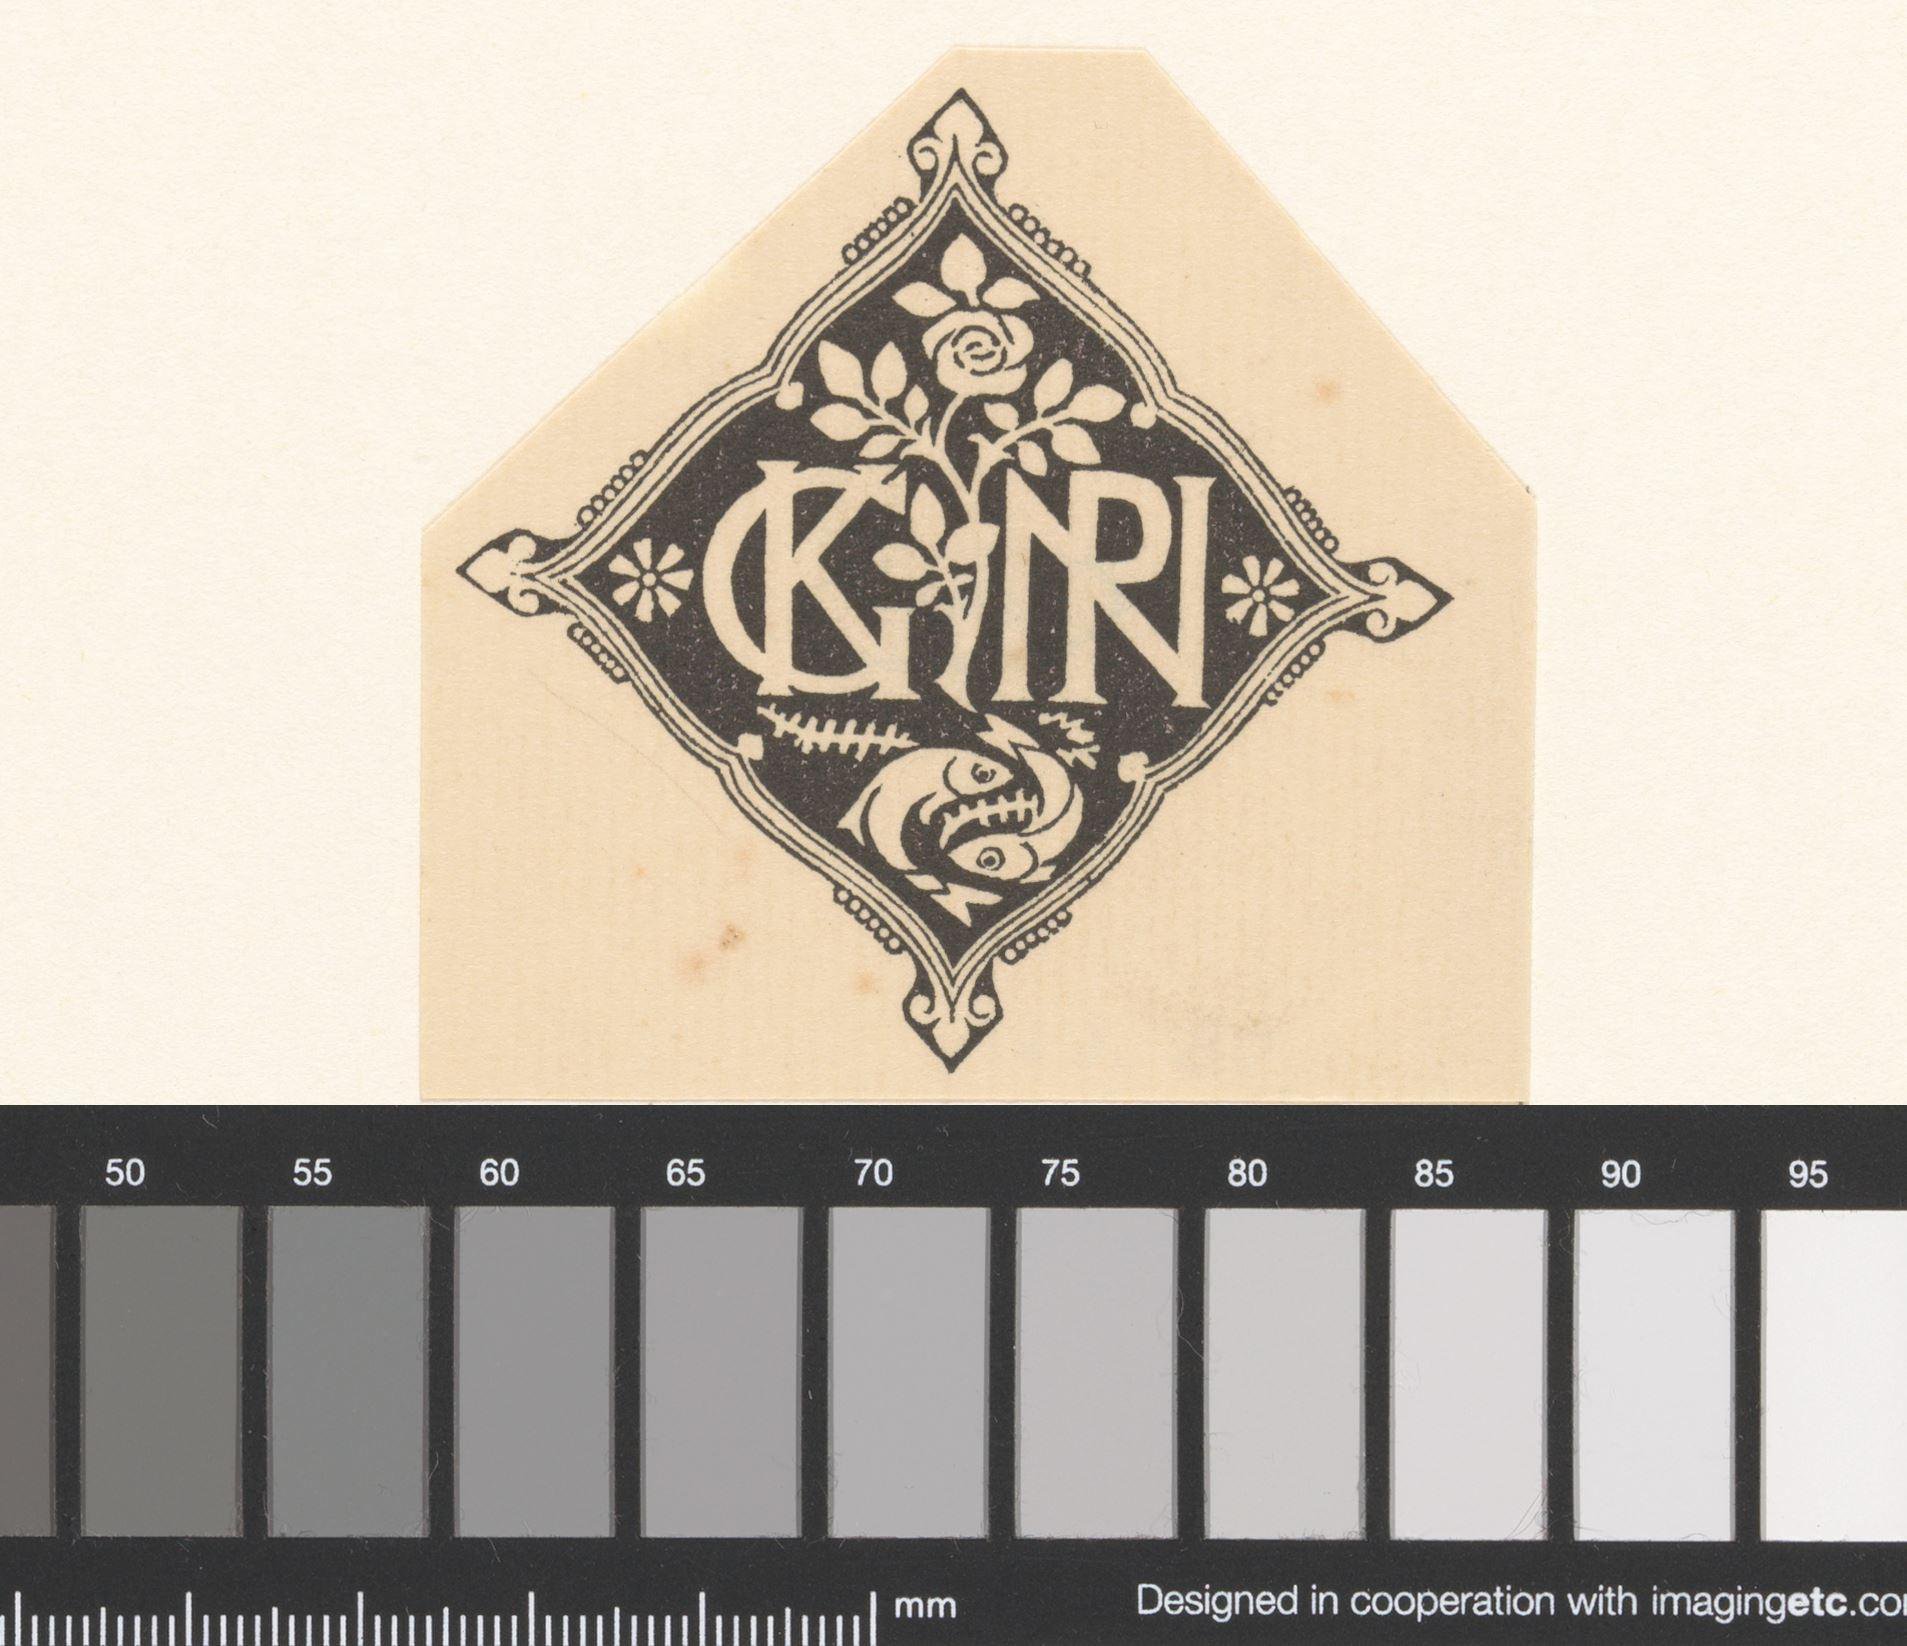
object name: print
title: Ex libris voor Klaas Groesbeek en Paul Nijhoff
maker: gerrit willem dijsselhof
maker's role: designer, draughtsman, print maker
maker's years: 1866-1924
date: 1876-1924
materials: paper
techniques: woodcut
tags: klaas groesbeek, fishes, shrubs: rose-bush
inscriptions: collector's mark: Lugt 2228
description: De initialen van Klaas Groesbeek en Paul Nijhoff, de directeuren van boekhandel Scheltema & Holkema in Amsterdam, in een ruit die verder is opgevuld met een rozenstruik en twee vissen.